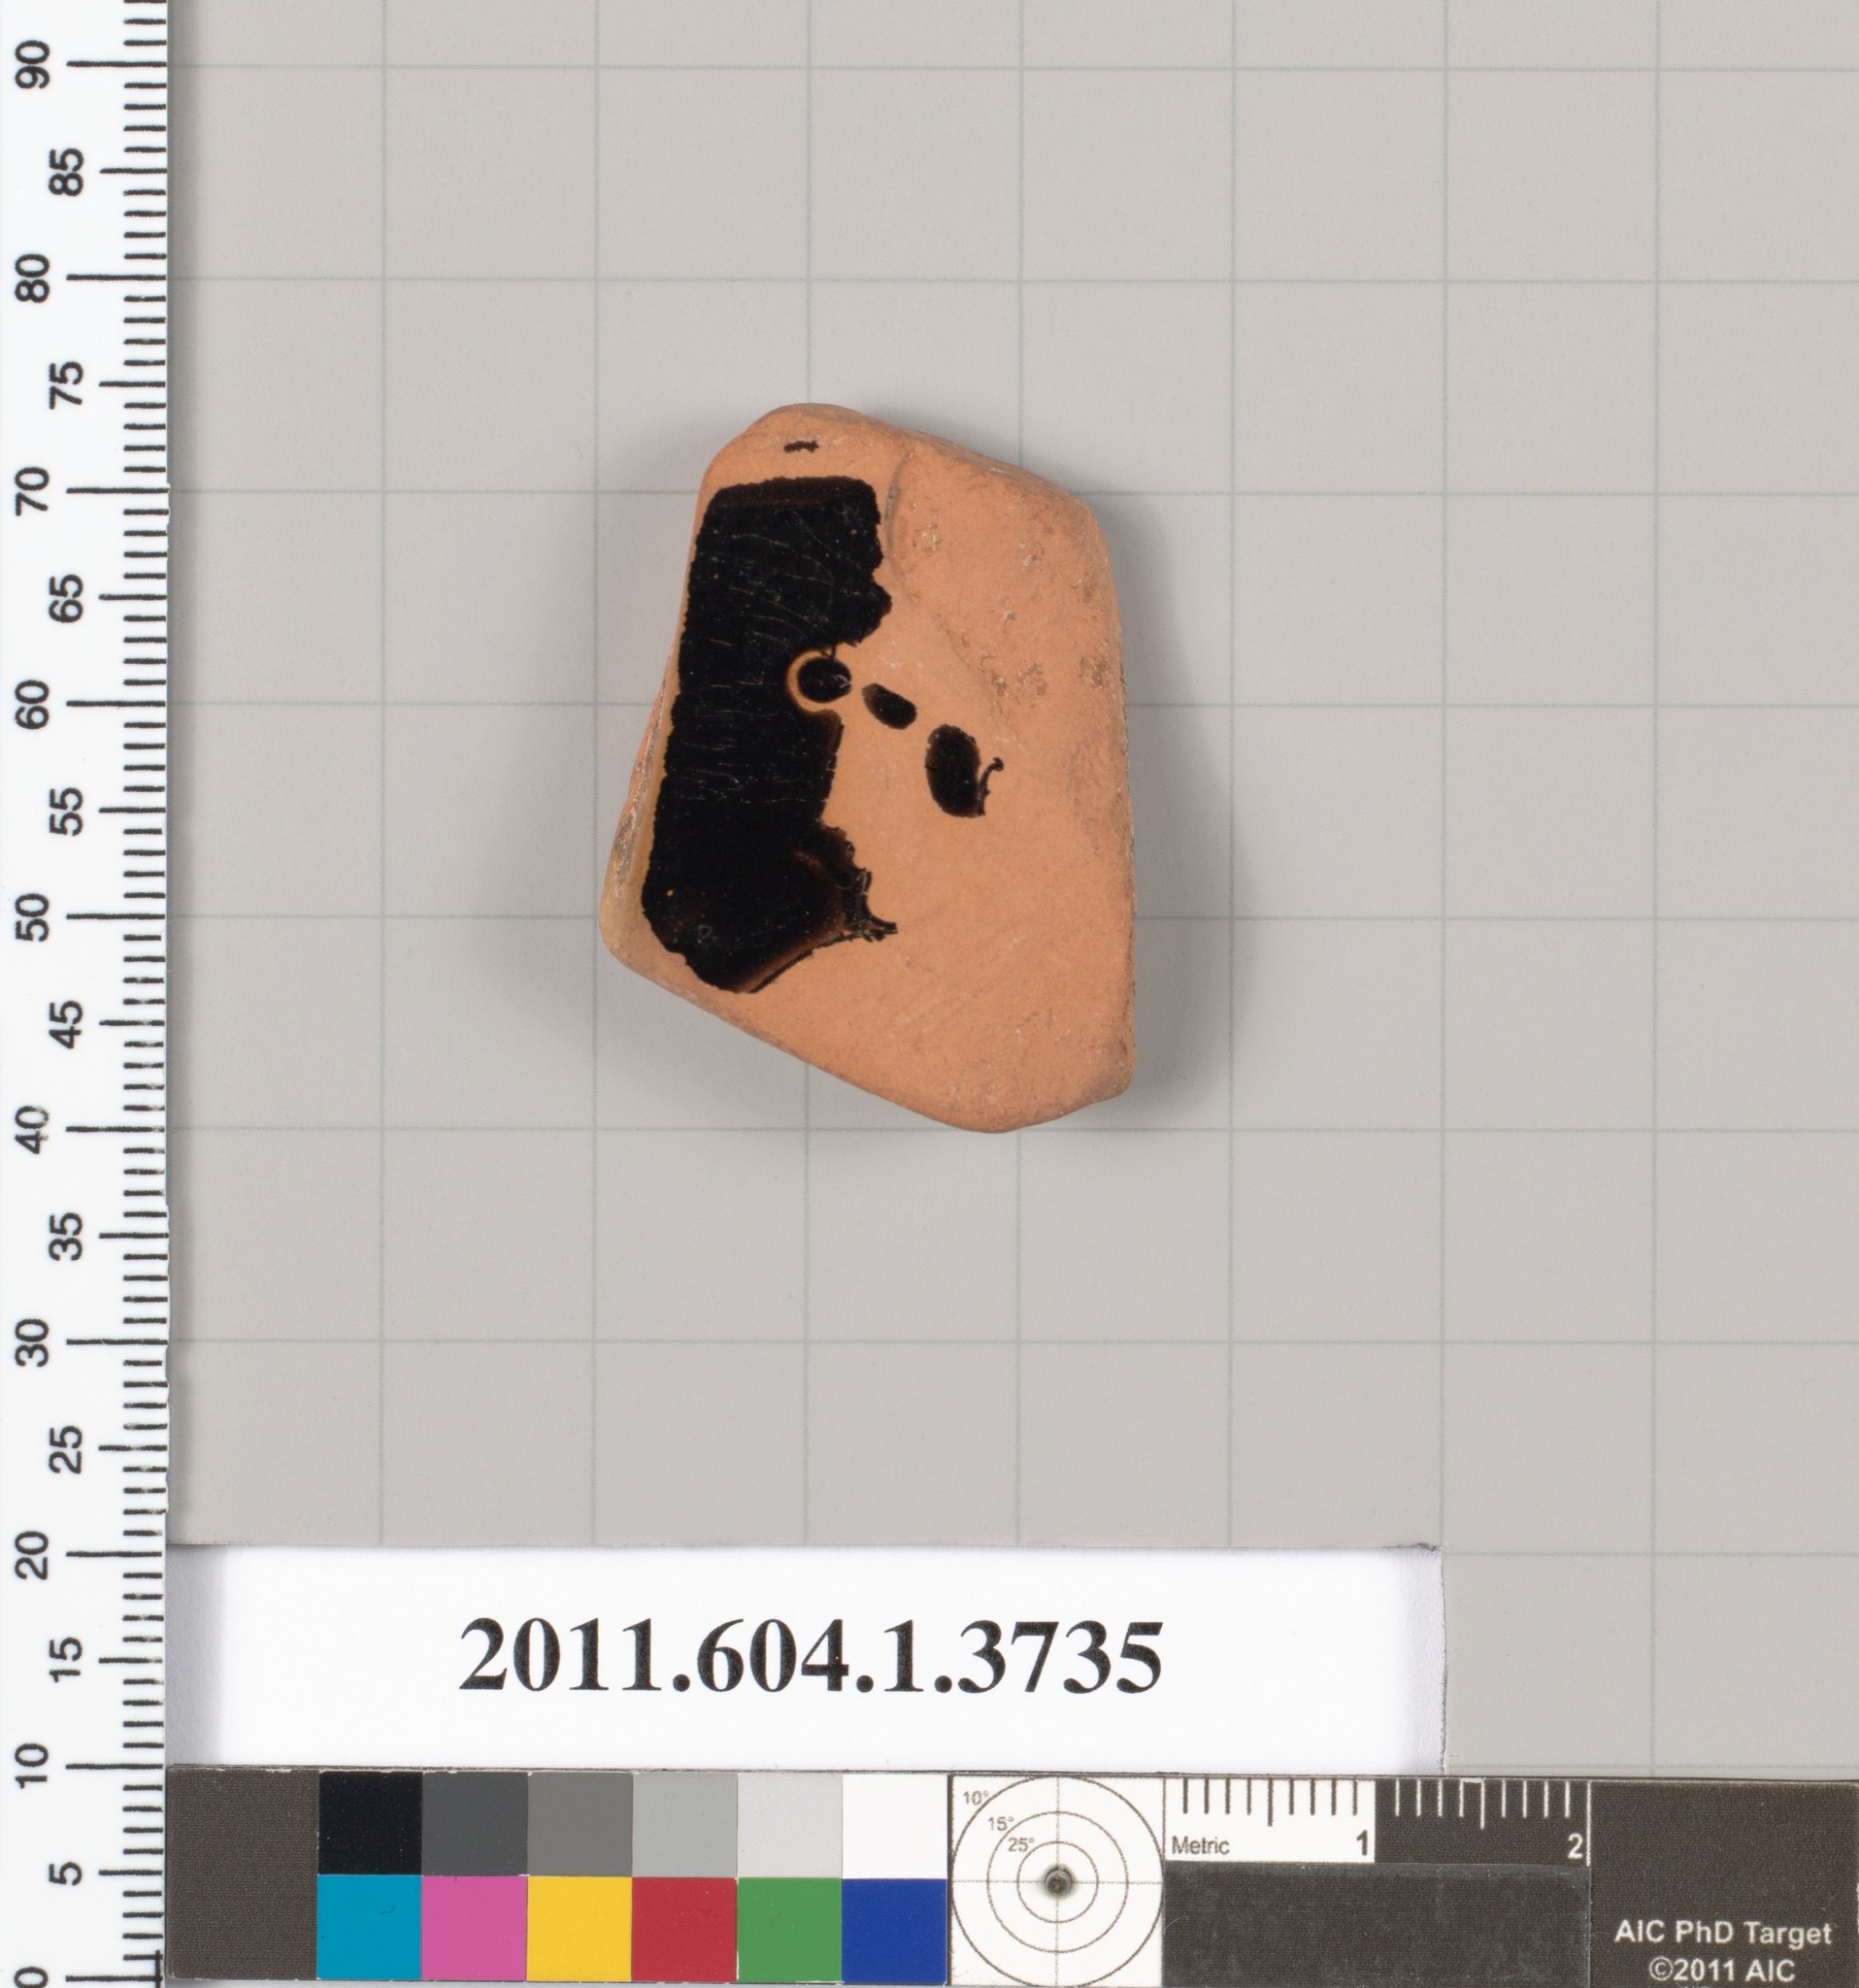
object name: kylix fragment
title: Terracotta fragment of a kylix (drinking cup)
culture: greek, attic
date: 500-476 BCE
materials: terracotta